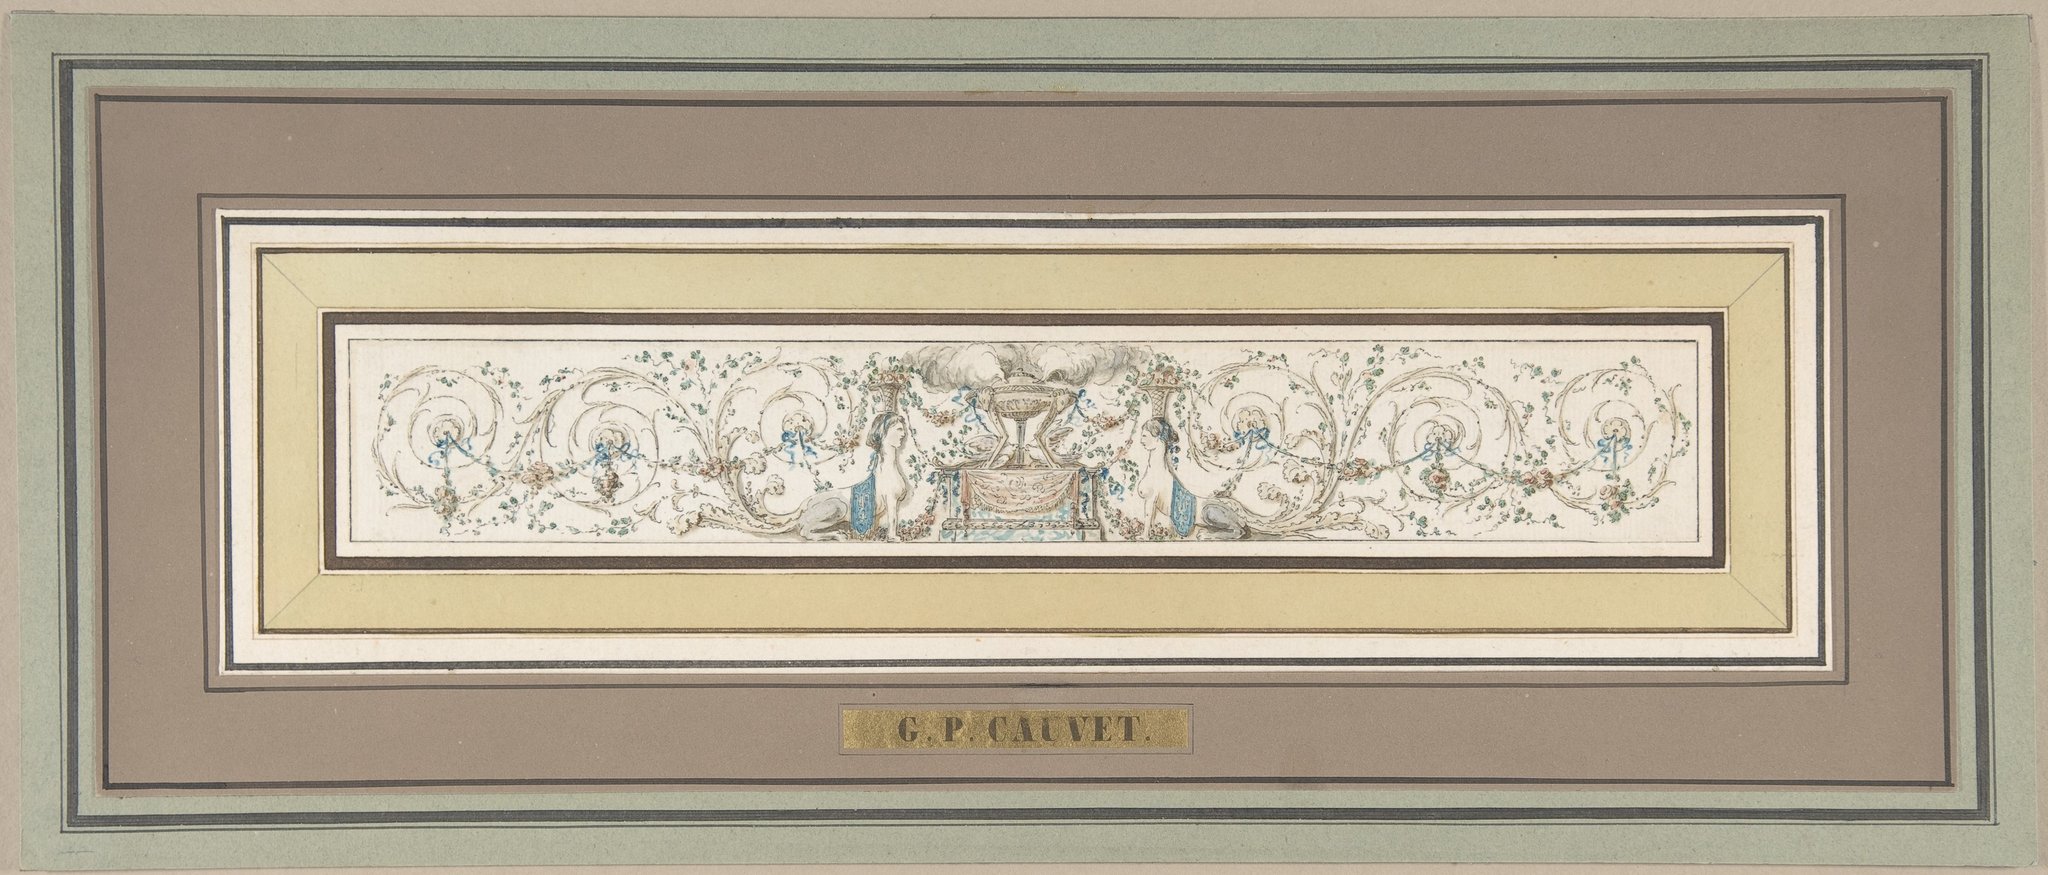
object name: drawing ornament architecture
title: Design for a Frieze with a Censer, Sphinxes and Acanthus Scrolls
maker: gilles paul cauvet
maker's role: artist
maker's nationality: french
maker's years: 1731-1788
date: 1760-1780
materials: ink, watercolor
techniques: heightening, pen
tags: sphinx,plants,censers